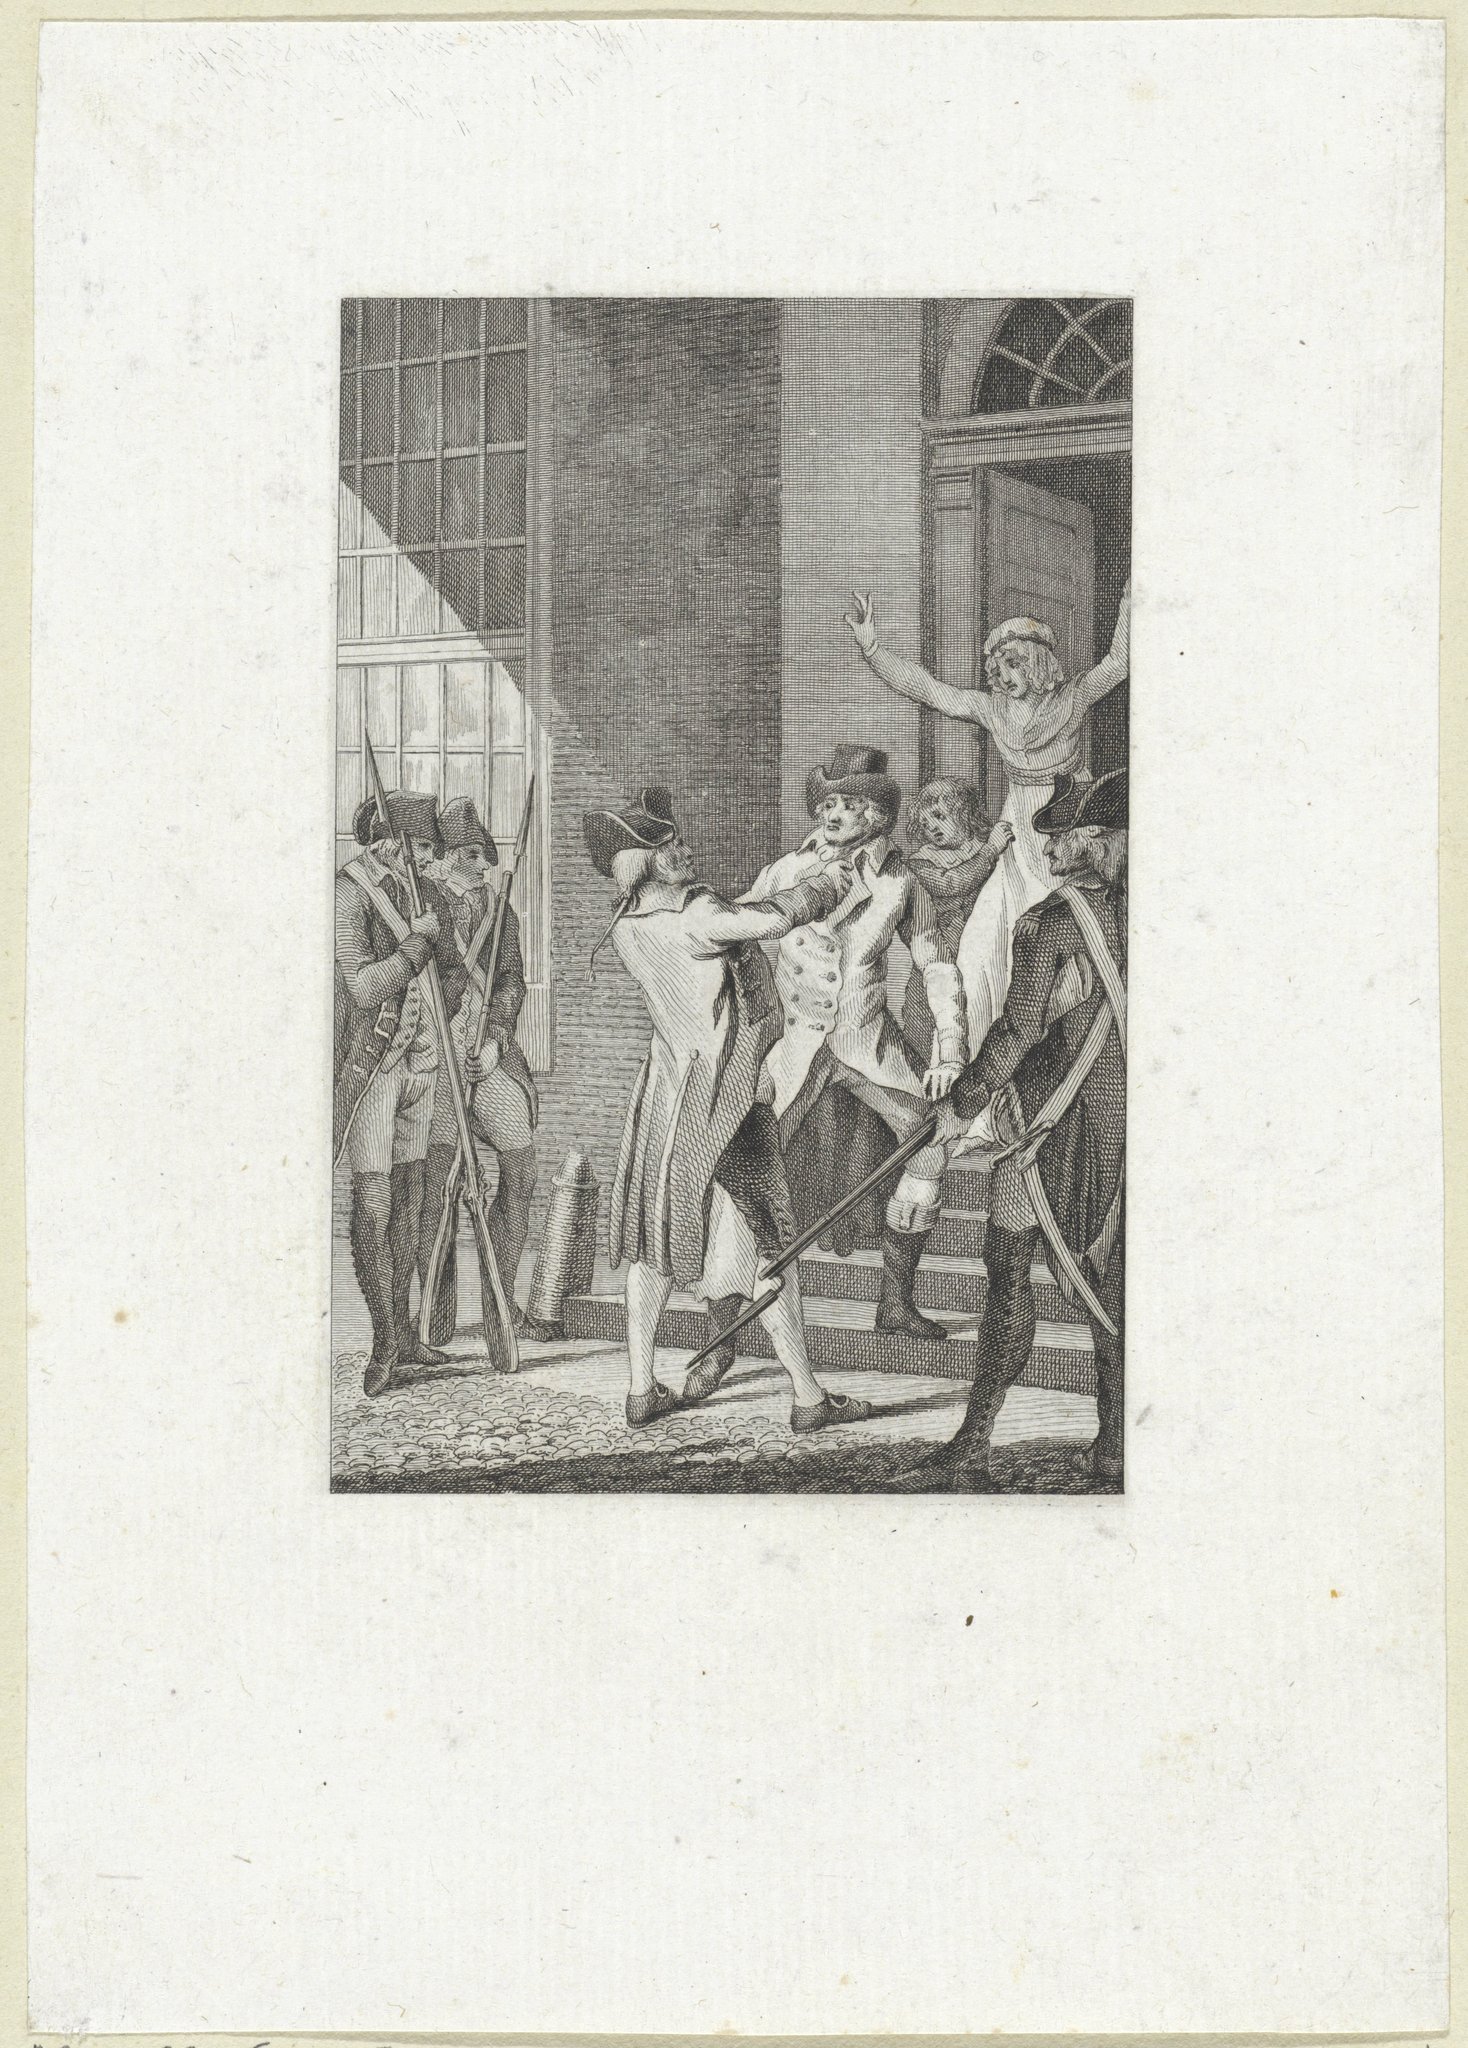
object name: print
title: Geschil tussen twee mannen voor een huis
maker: reinier vinkeles (i)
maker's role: draughtsman, print maker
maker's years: 1741-1816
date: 1798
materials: paper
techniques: engraving, etching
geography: amsterdam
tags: soldiers and civilians, family, descendance, quarrel, argument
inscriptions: collector's mark: Lugt 240